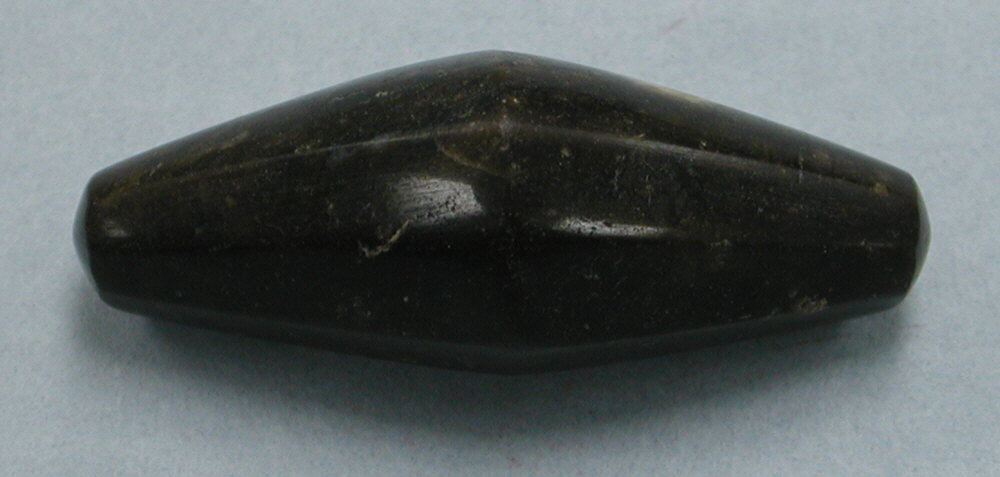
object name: ritual stone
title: Polishing Stone (pulidor)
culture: mexican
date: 1501-1600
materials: stone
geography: mexico